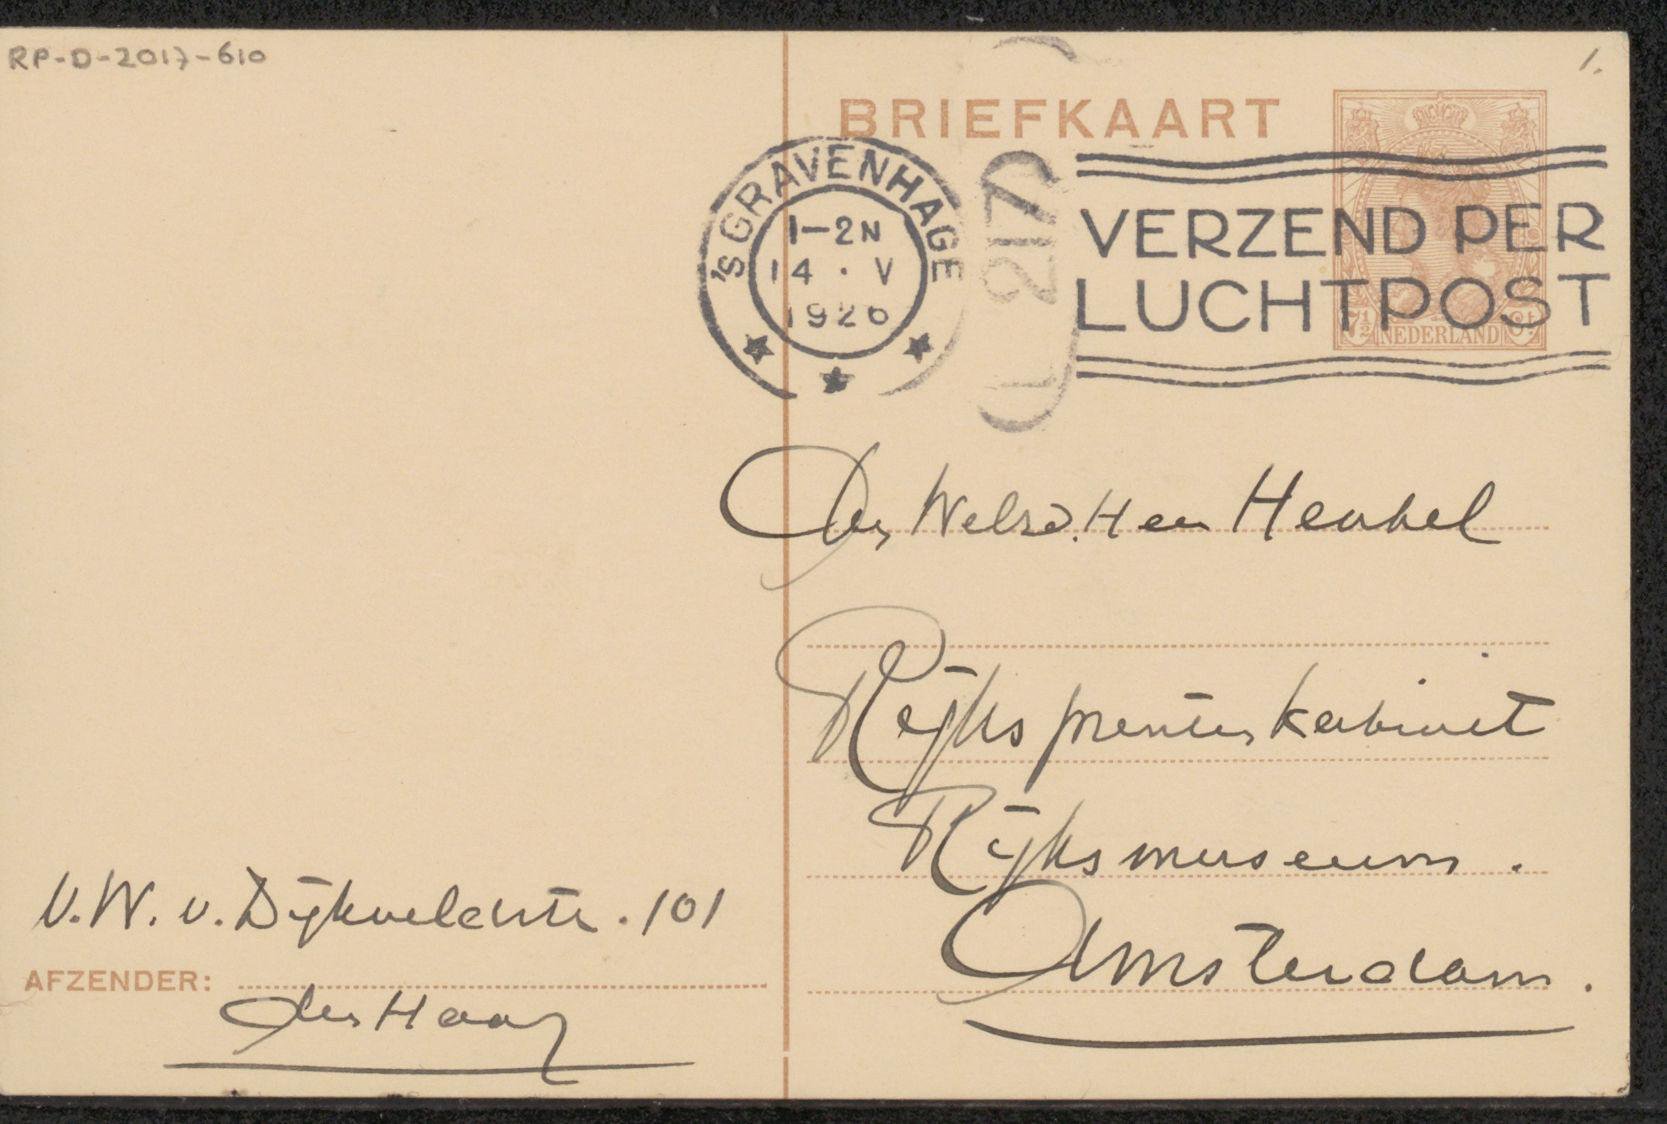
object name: postcard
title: Briefkaart aan Max Dittmar Henkel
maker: simon moulijn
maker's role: draughtsman, print maker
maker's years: 1866-1948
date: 1926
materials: cardboard, ink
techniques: pen, writing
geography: the hague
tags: print room, theodorus henricus kerstel, amsterdam, hendrik johannes haverman, printer, publisher, max dittmar henkel